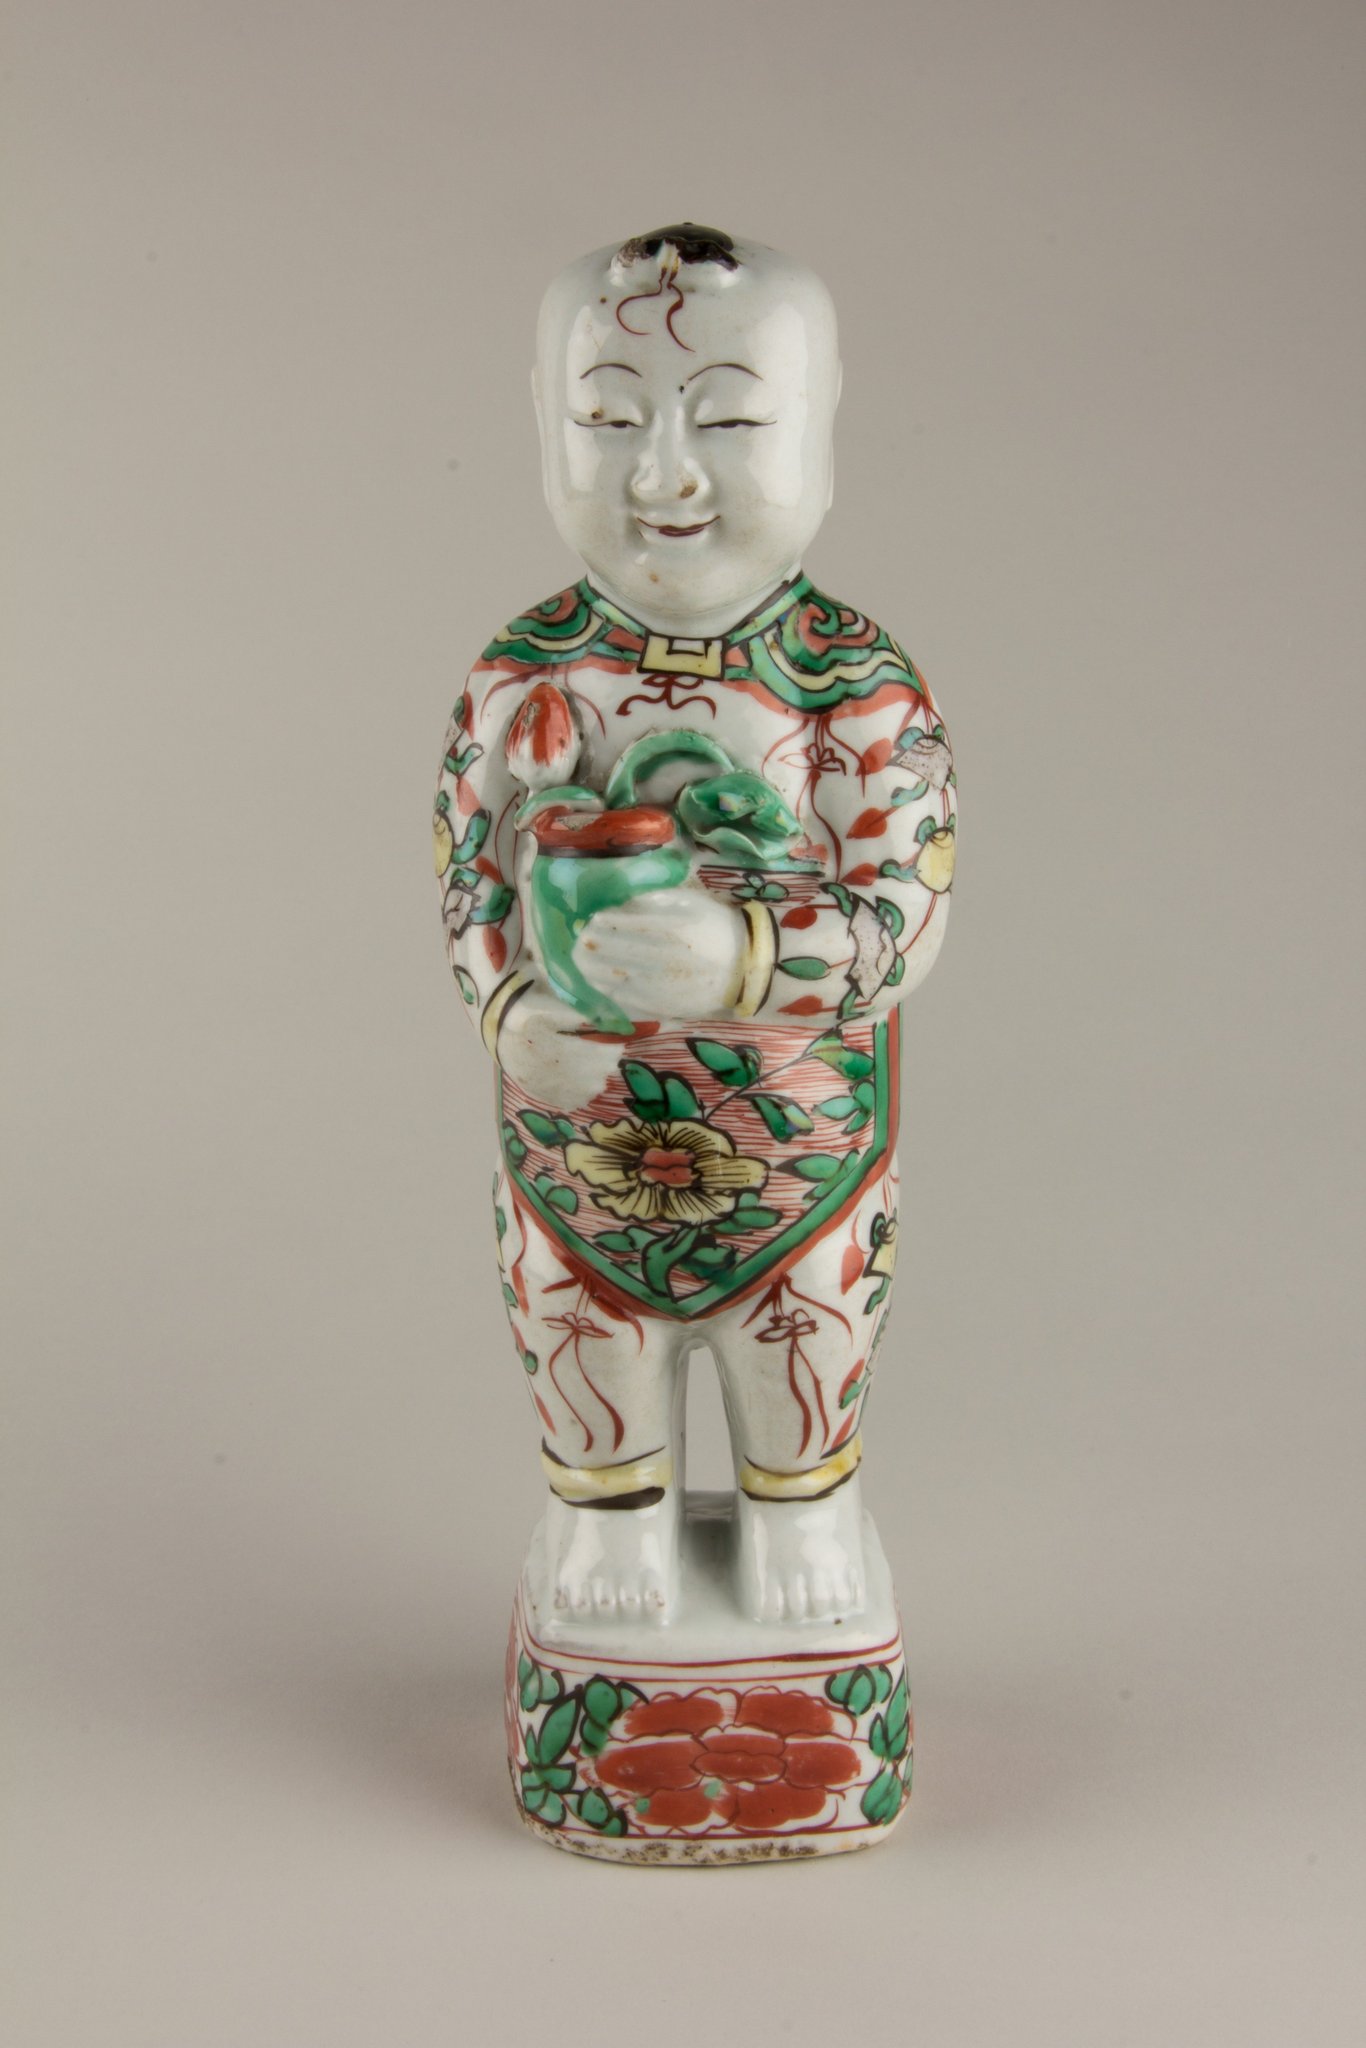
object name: figure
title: Figure of a Boy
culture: chinese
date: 1368-1644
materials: enamel, porcelain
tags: boys,flowers